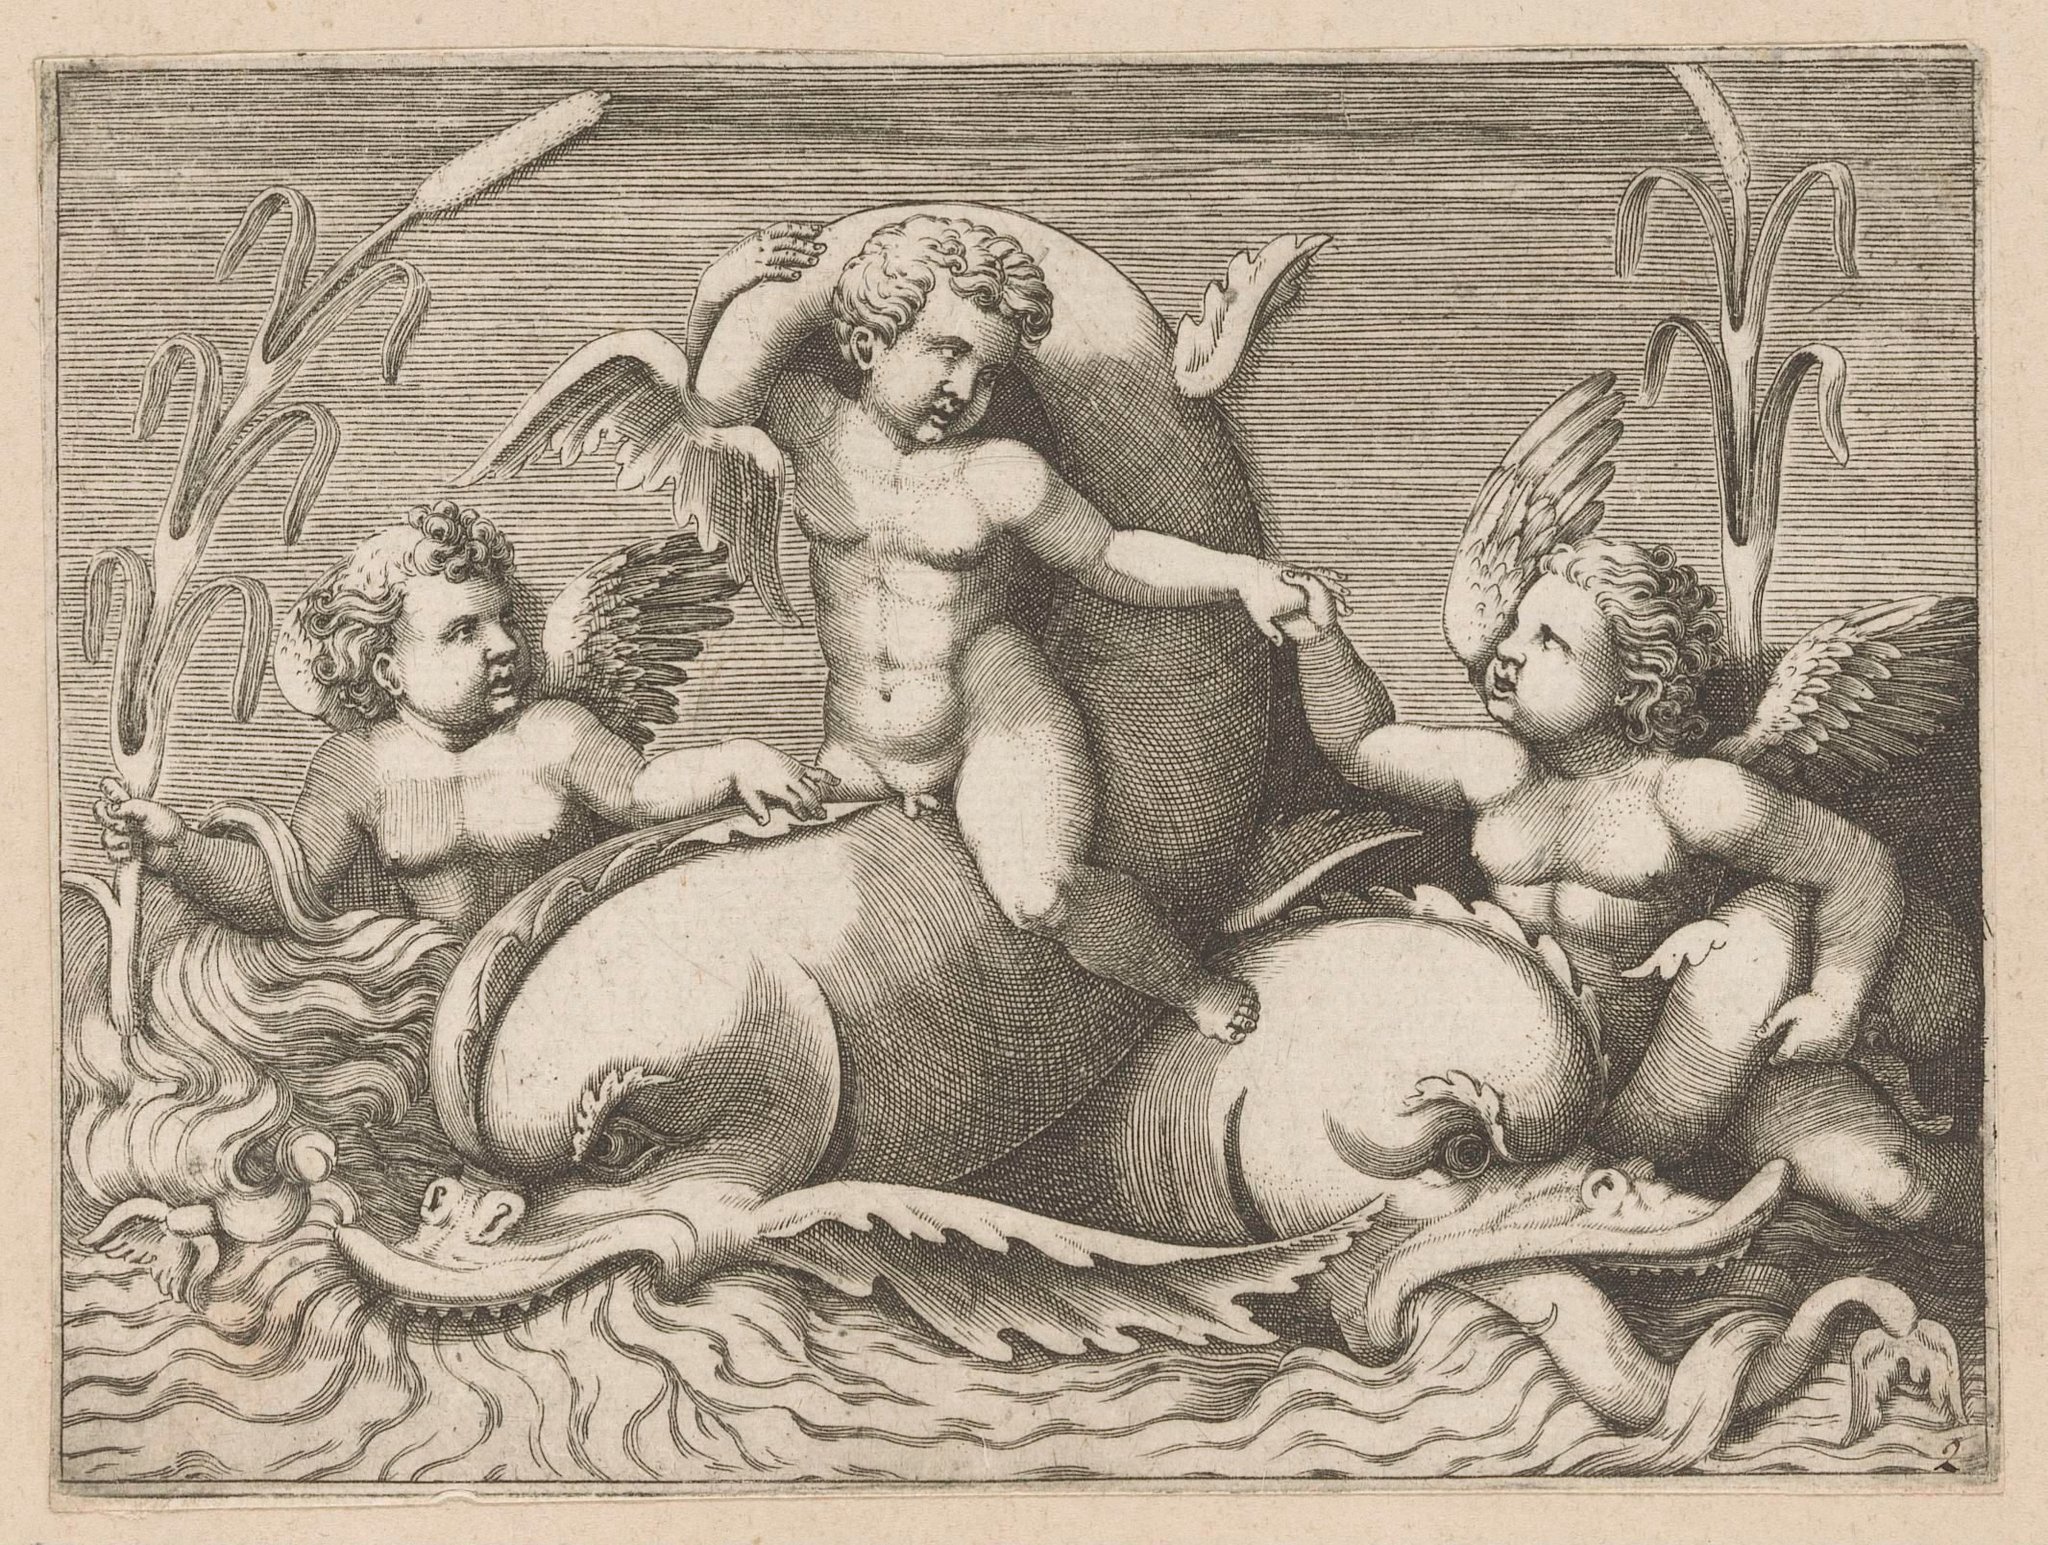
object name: print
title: Drie putti met dolfijnen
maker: Anonymous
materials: paper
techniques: engraving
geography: italy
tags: swimming mammals: dolphin, cupids: 'amores', 'amoretti', 'putti'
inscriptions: collector's mark: ‘Hinloopen’, collector's mark: Lugt 11, collector's mark: Lugt 10, number: ‘2’